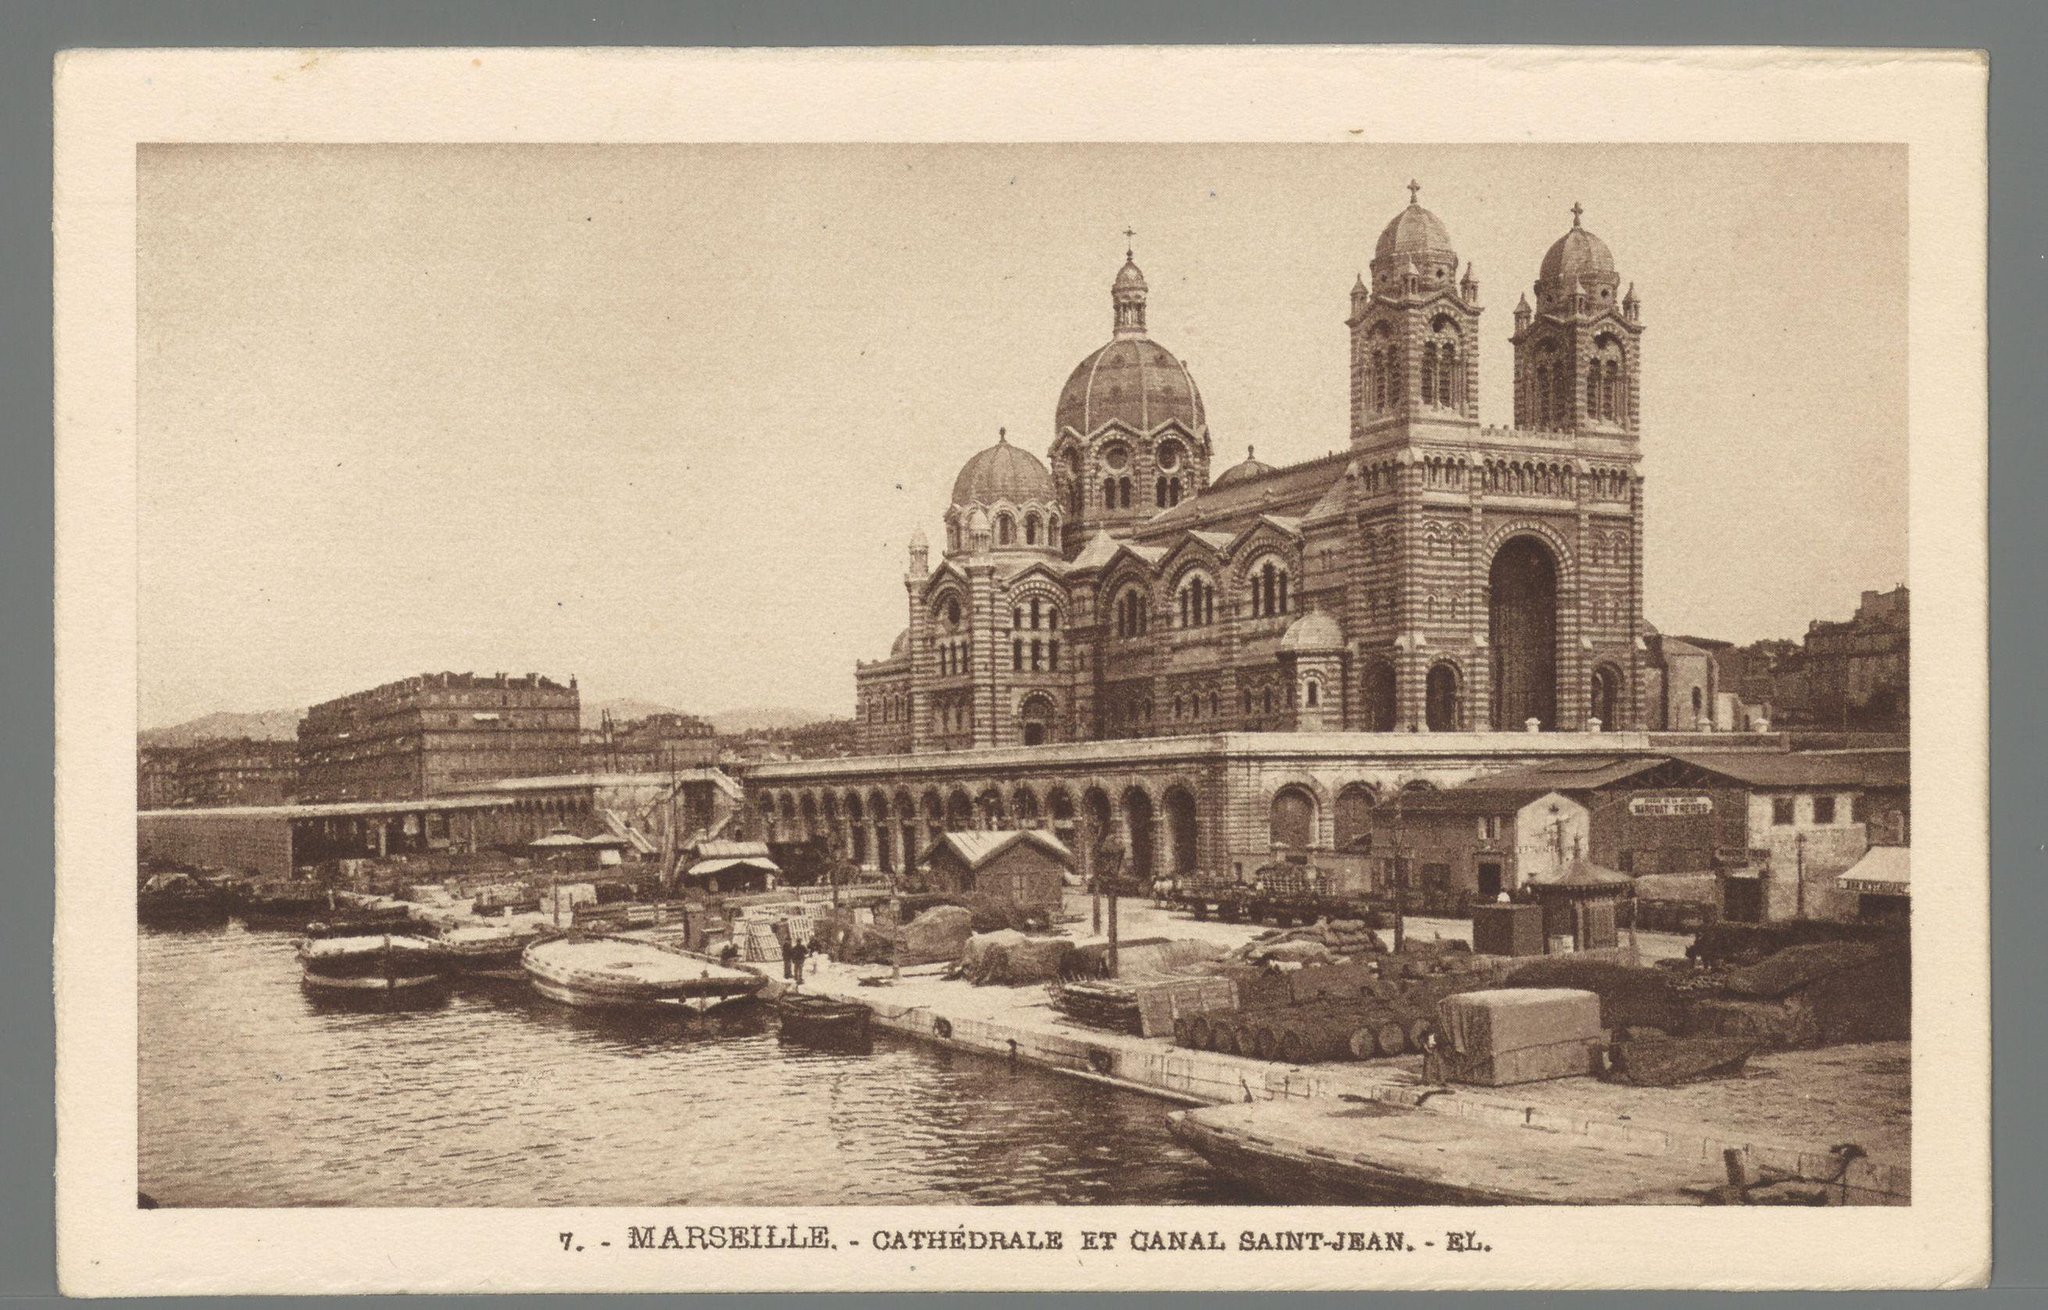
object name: photomechanical print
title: Marseille. Cathédrale et Canal Saint-Jean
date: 1903-1913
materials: cardboard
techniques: rotogravure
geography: marseille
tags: canal, church (exterior), city-view, and landscape with man-made constructions (+ city(-scape) with figures, staffage), marseille